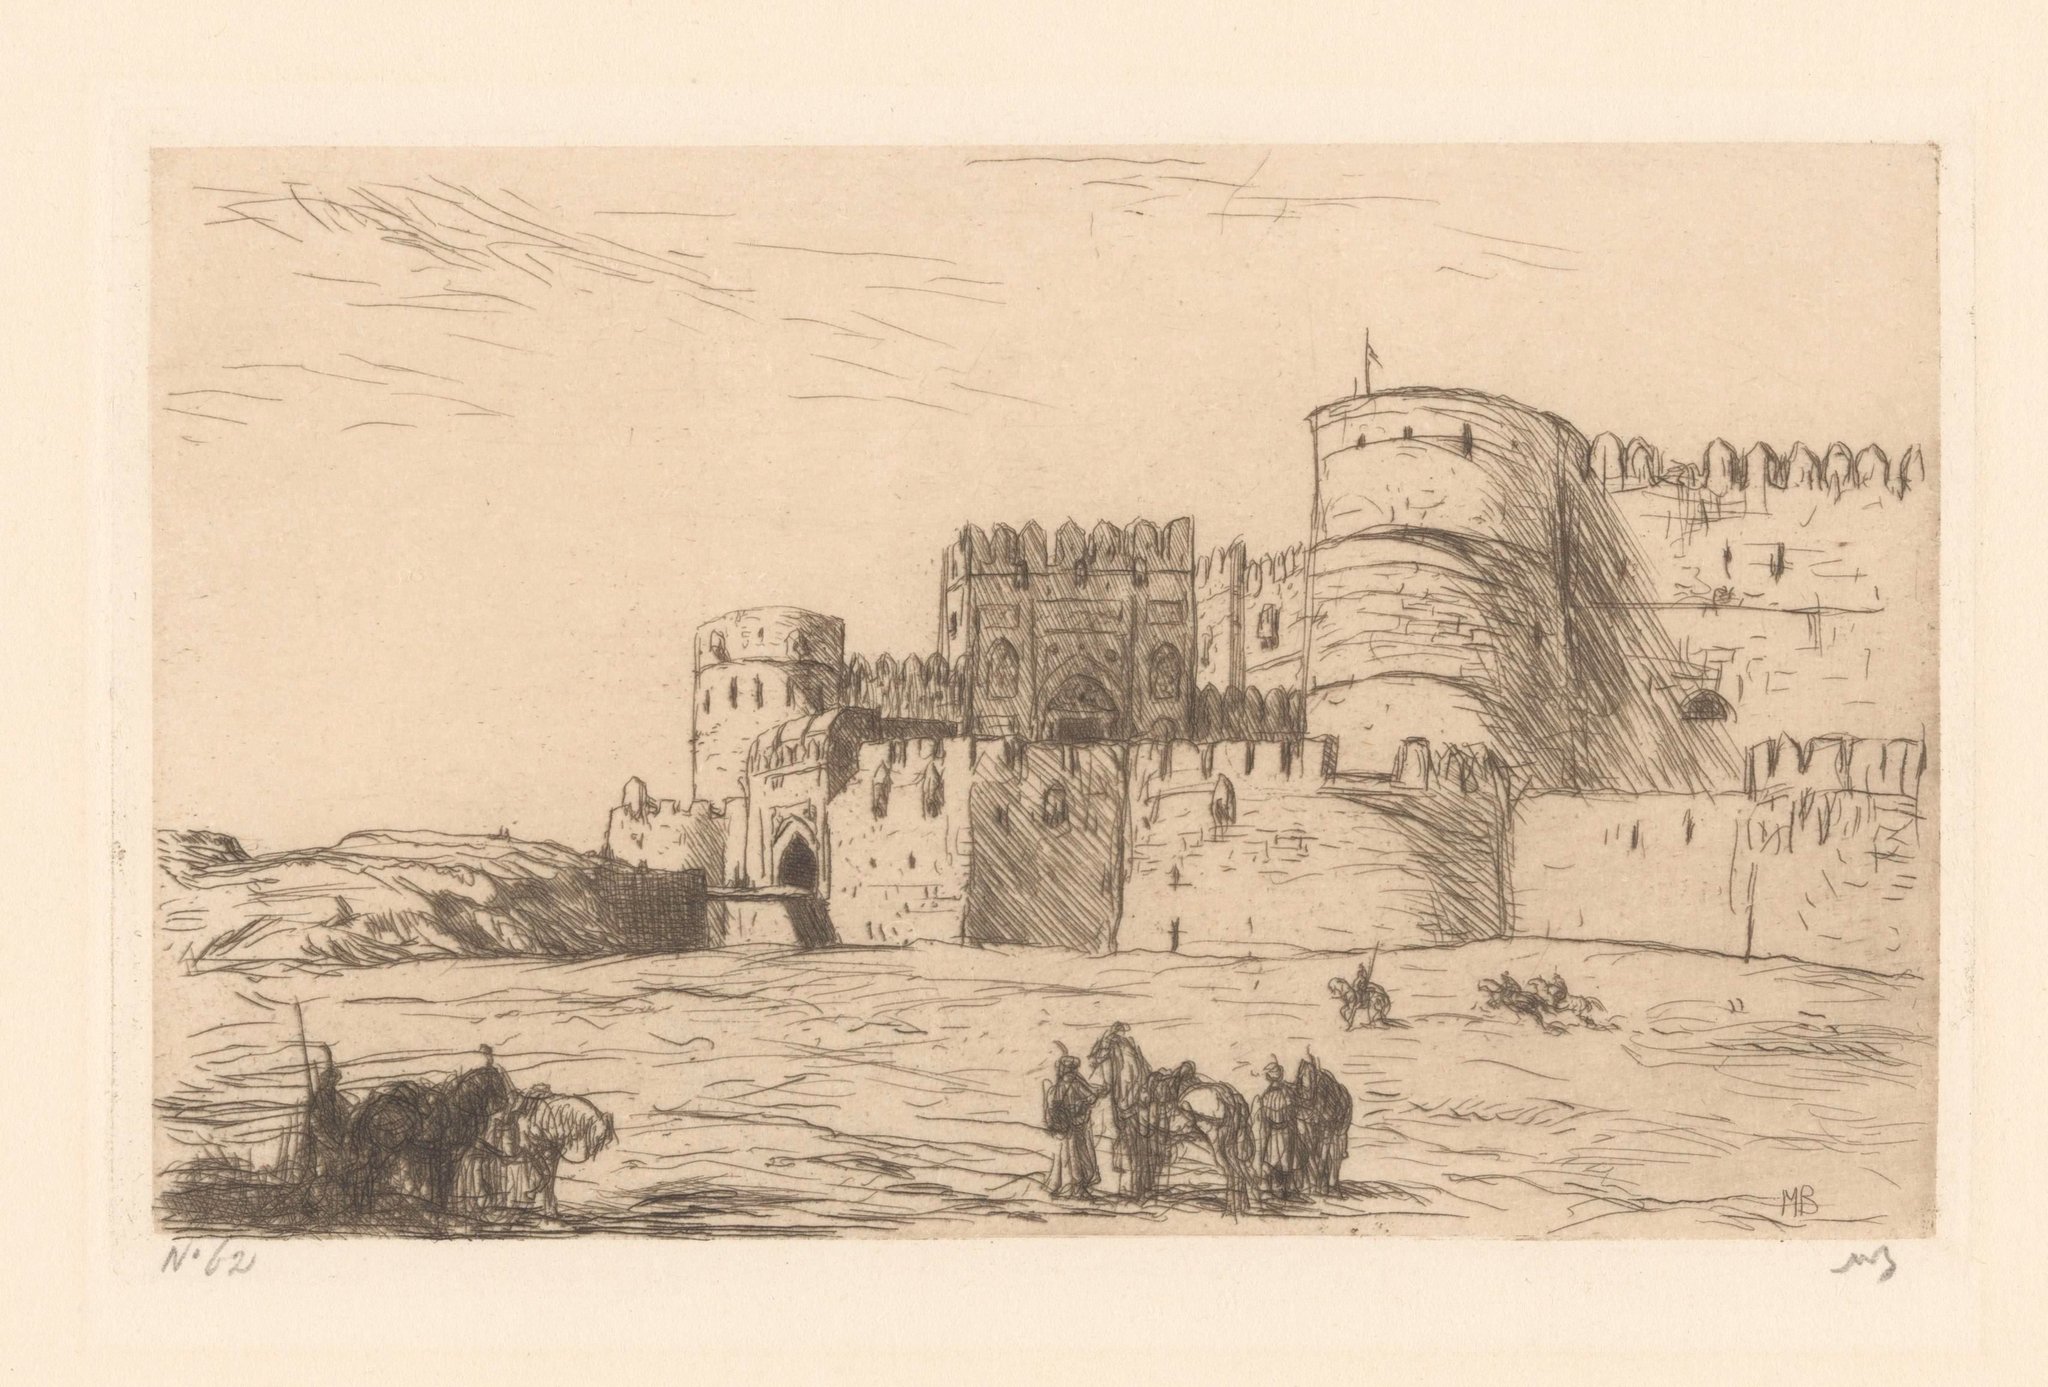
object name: print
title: Fort van Agra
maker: marius bauer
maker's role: draughtsman, print maker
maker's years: 1867-1932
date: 1895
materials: paper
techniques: etching, intaglio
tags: riding a horse, ass, or mule; rider, horseman, walls ~ fortified city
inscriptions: collector's mark: Lugt 2228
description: Gezicht op het fort van Agra. Op de voorgrond enkele ruiters.